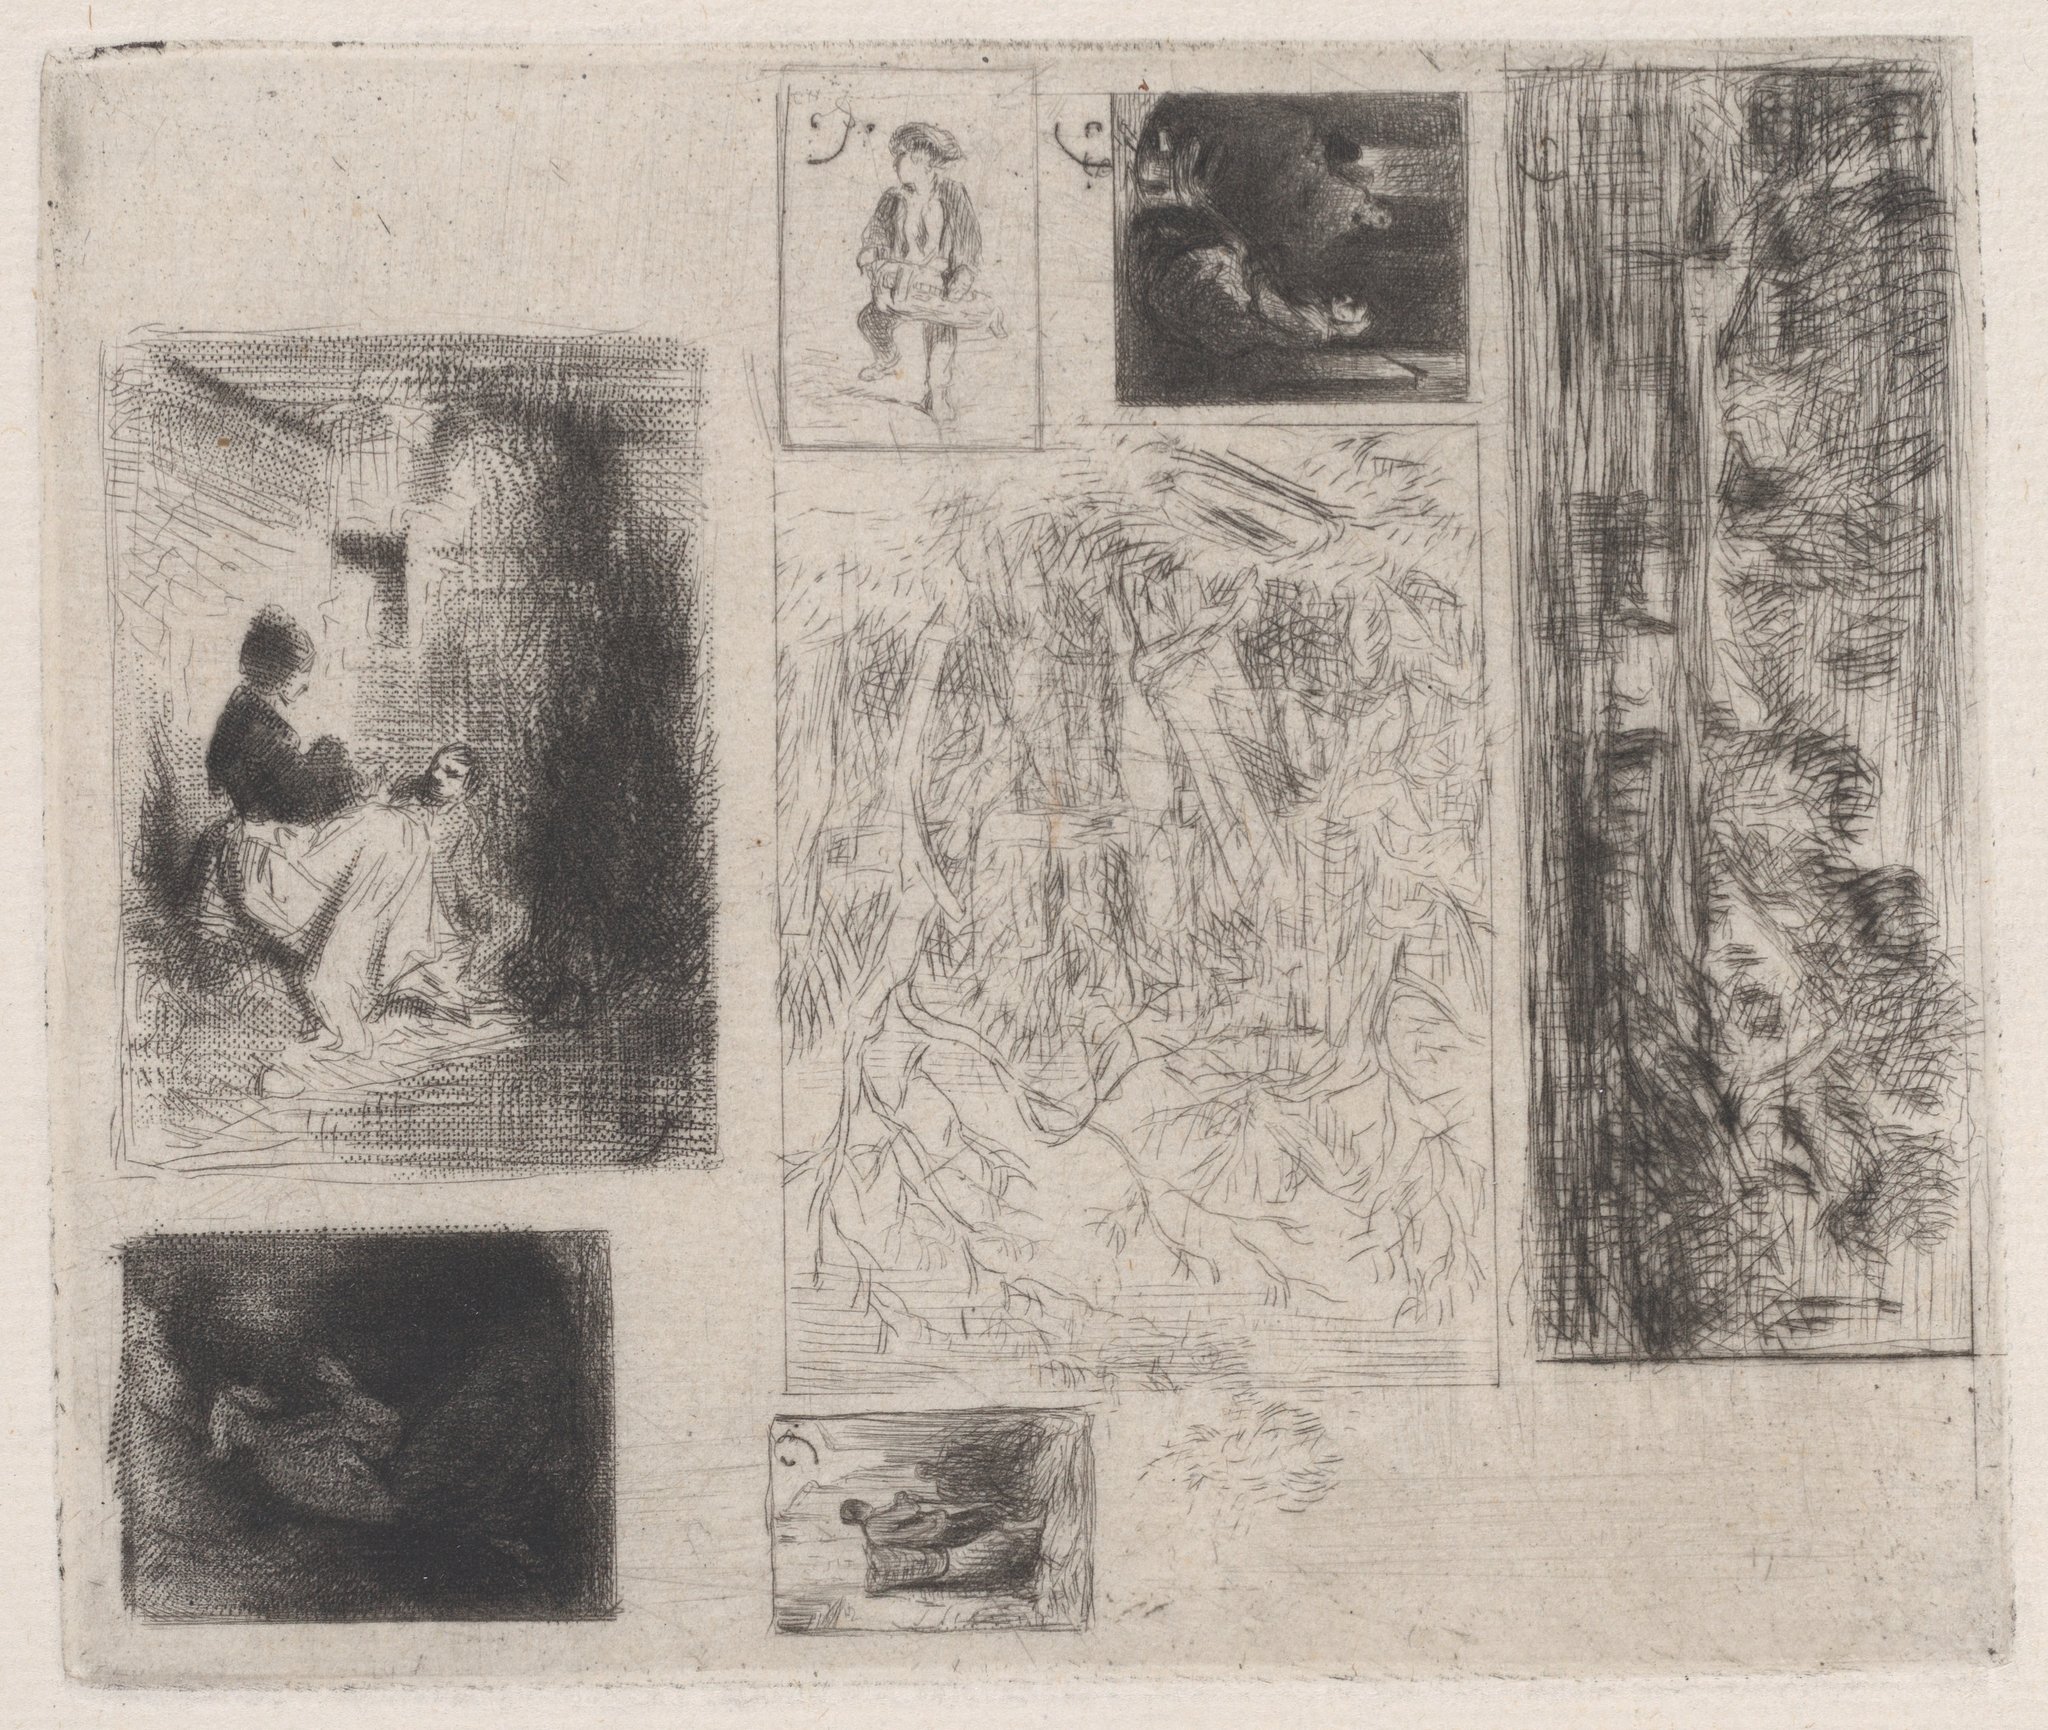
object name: print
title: Composite plate: Woman and Children (a), Old Musician (b), Frying Merchant (c), Landscape (d), Landscape (e), Praying Monk (f), and Scavenger (g)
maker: charles émile jacque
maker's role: artist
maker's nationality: french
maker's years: 1813-1894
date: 1843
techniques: drypoint